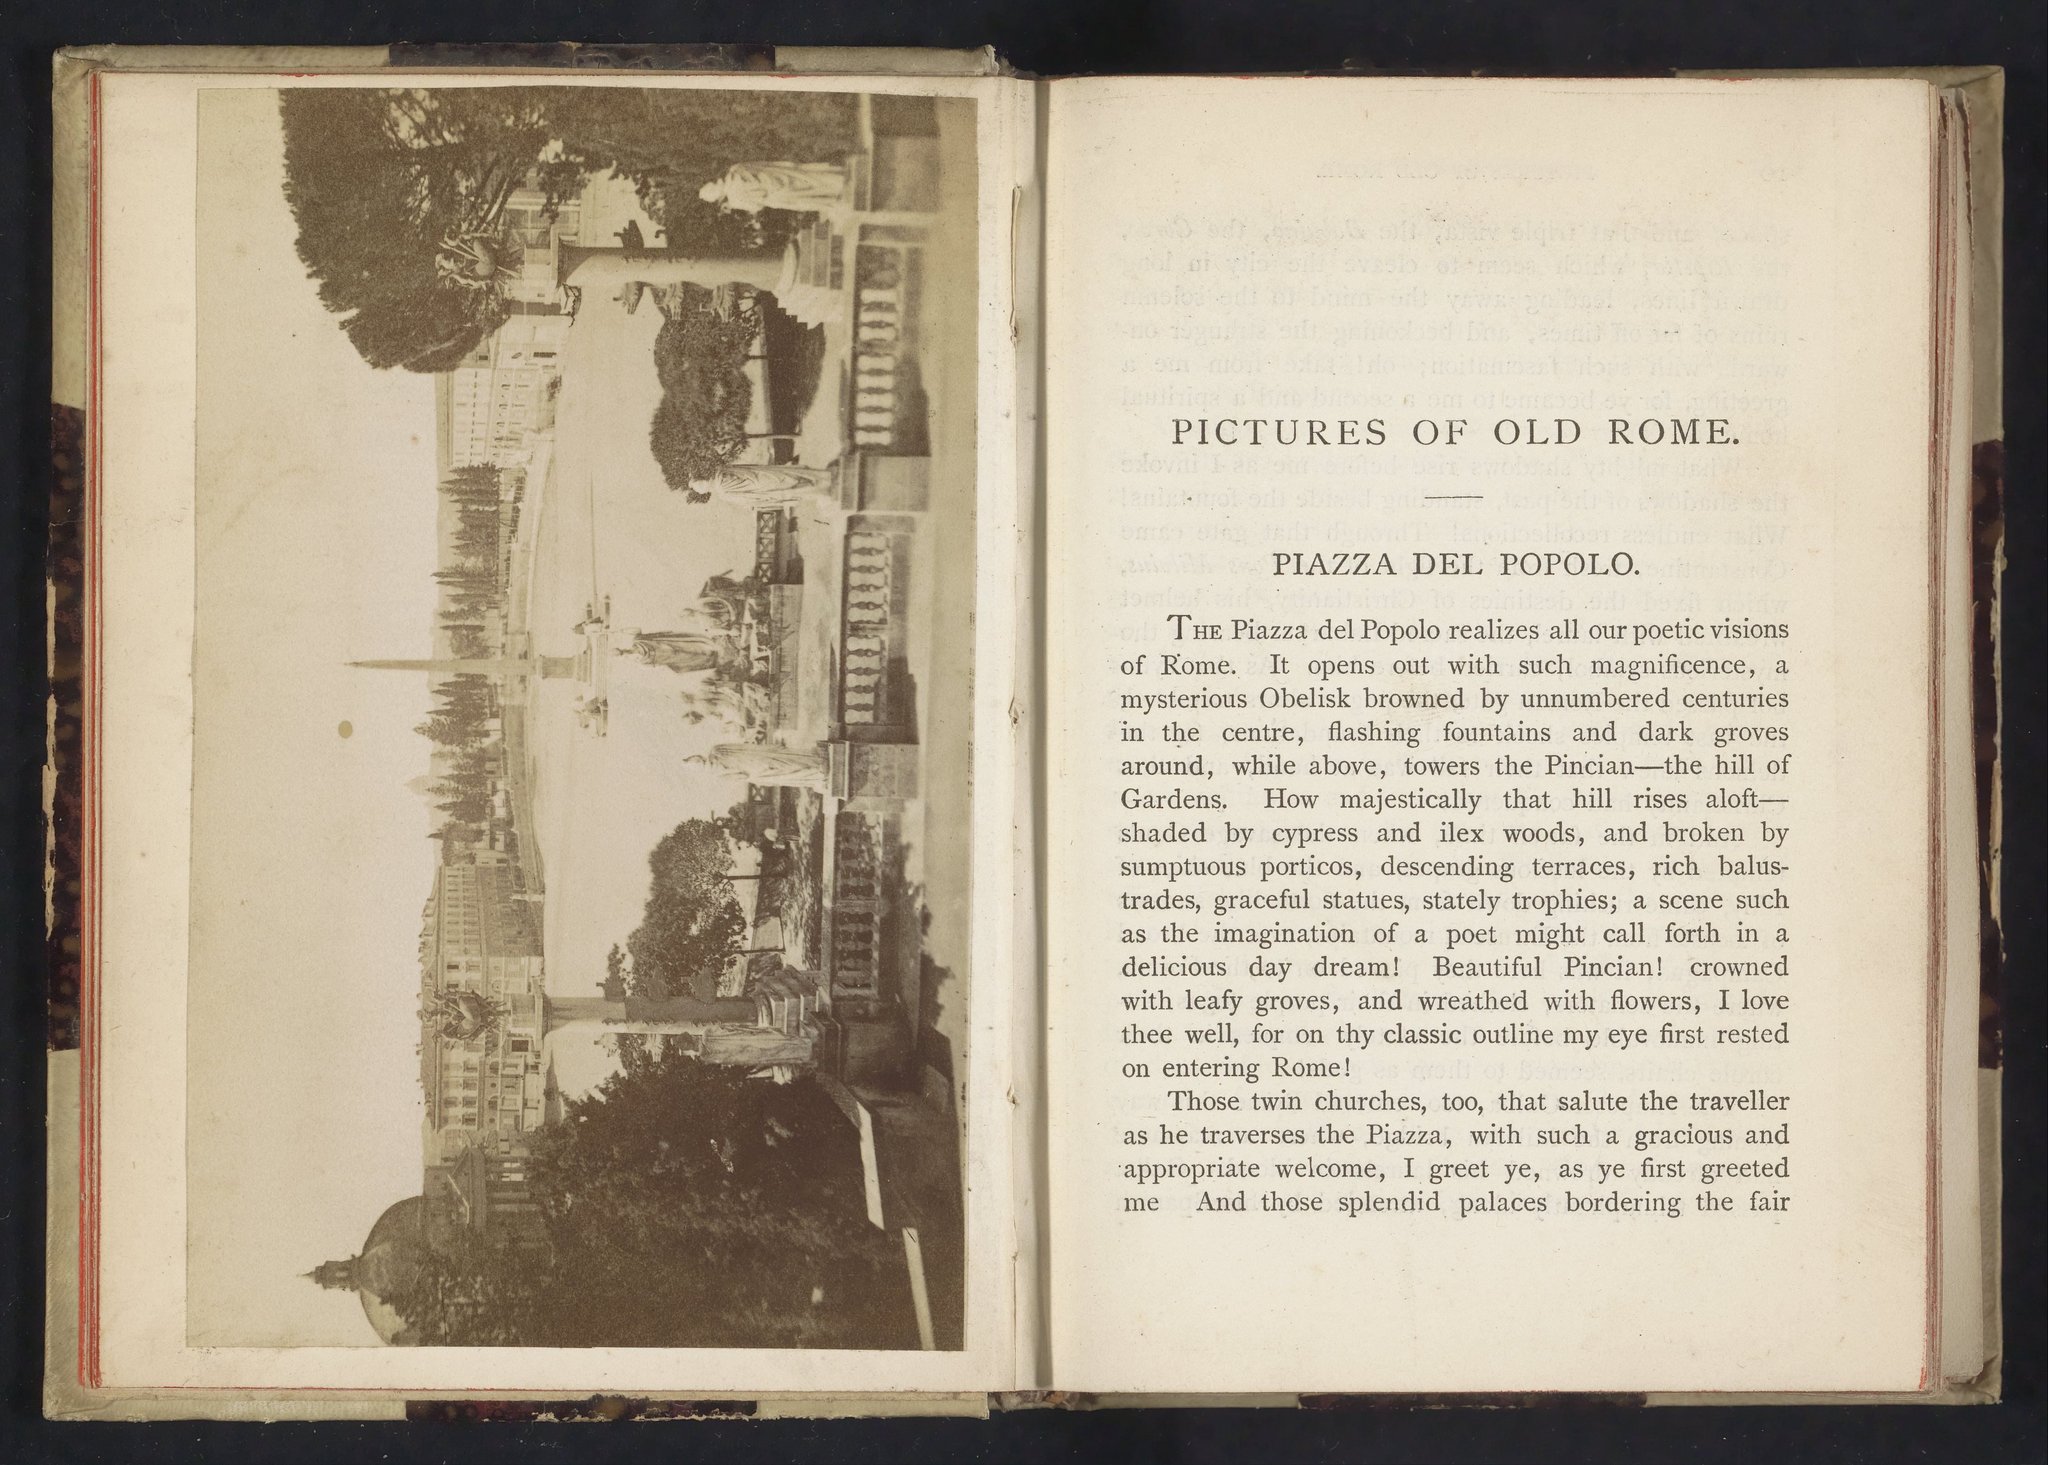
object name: photograph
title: Gezicht op het Piazza del Popolo te Rome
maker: Anonymous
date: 1872-1882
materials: photographic support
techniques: albumen print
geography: pincio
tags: square, place, circus, etc., obelisk, needle